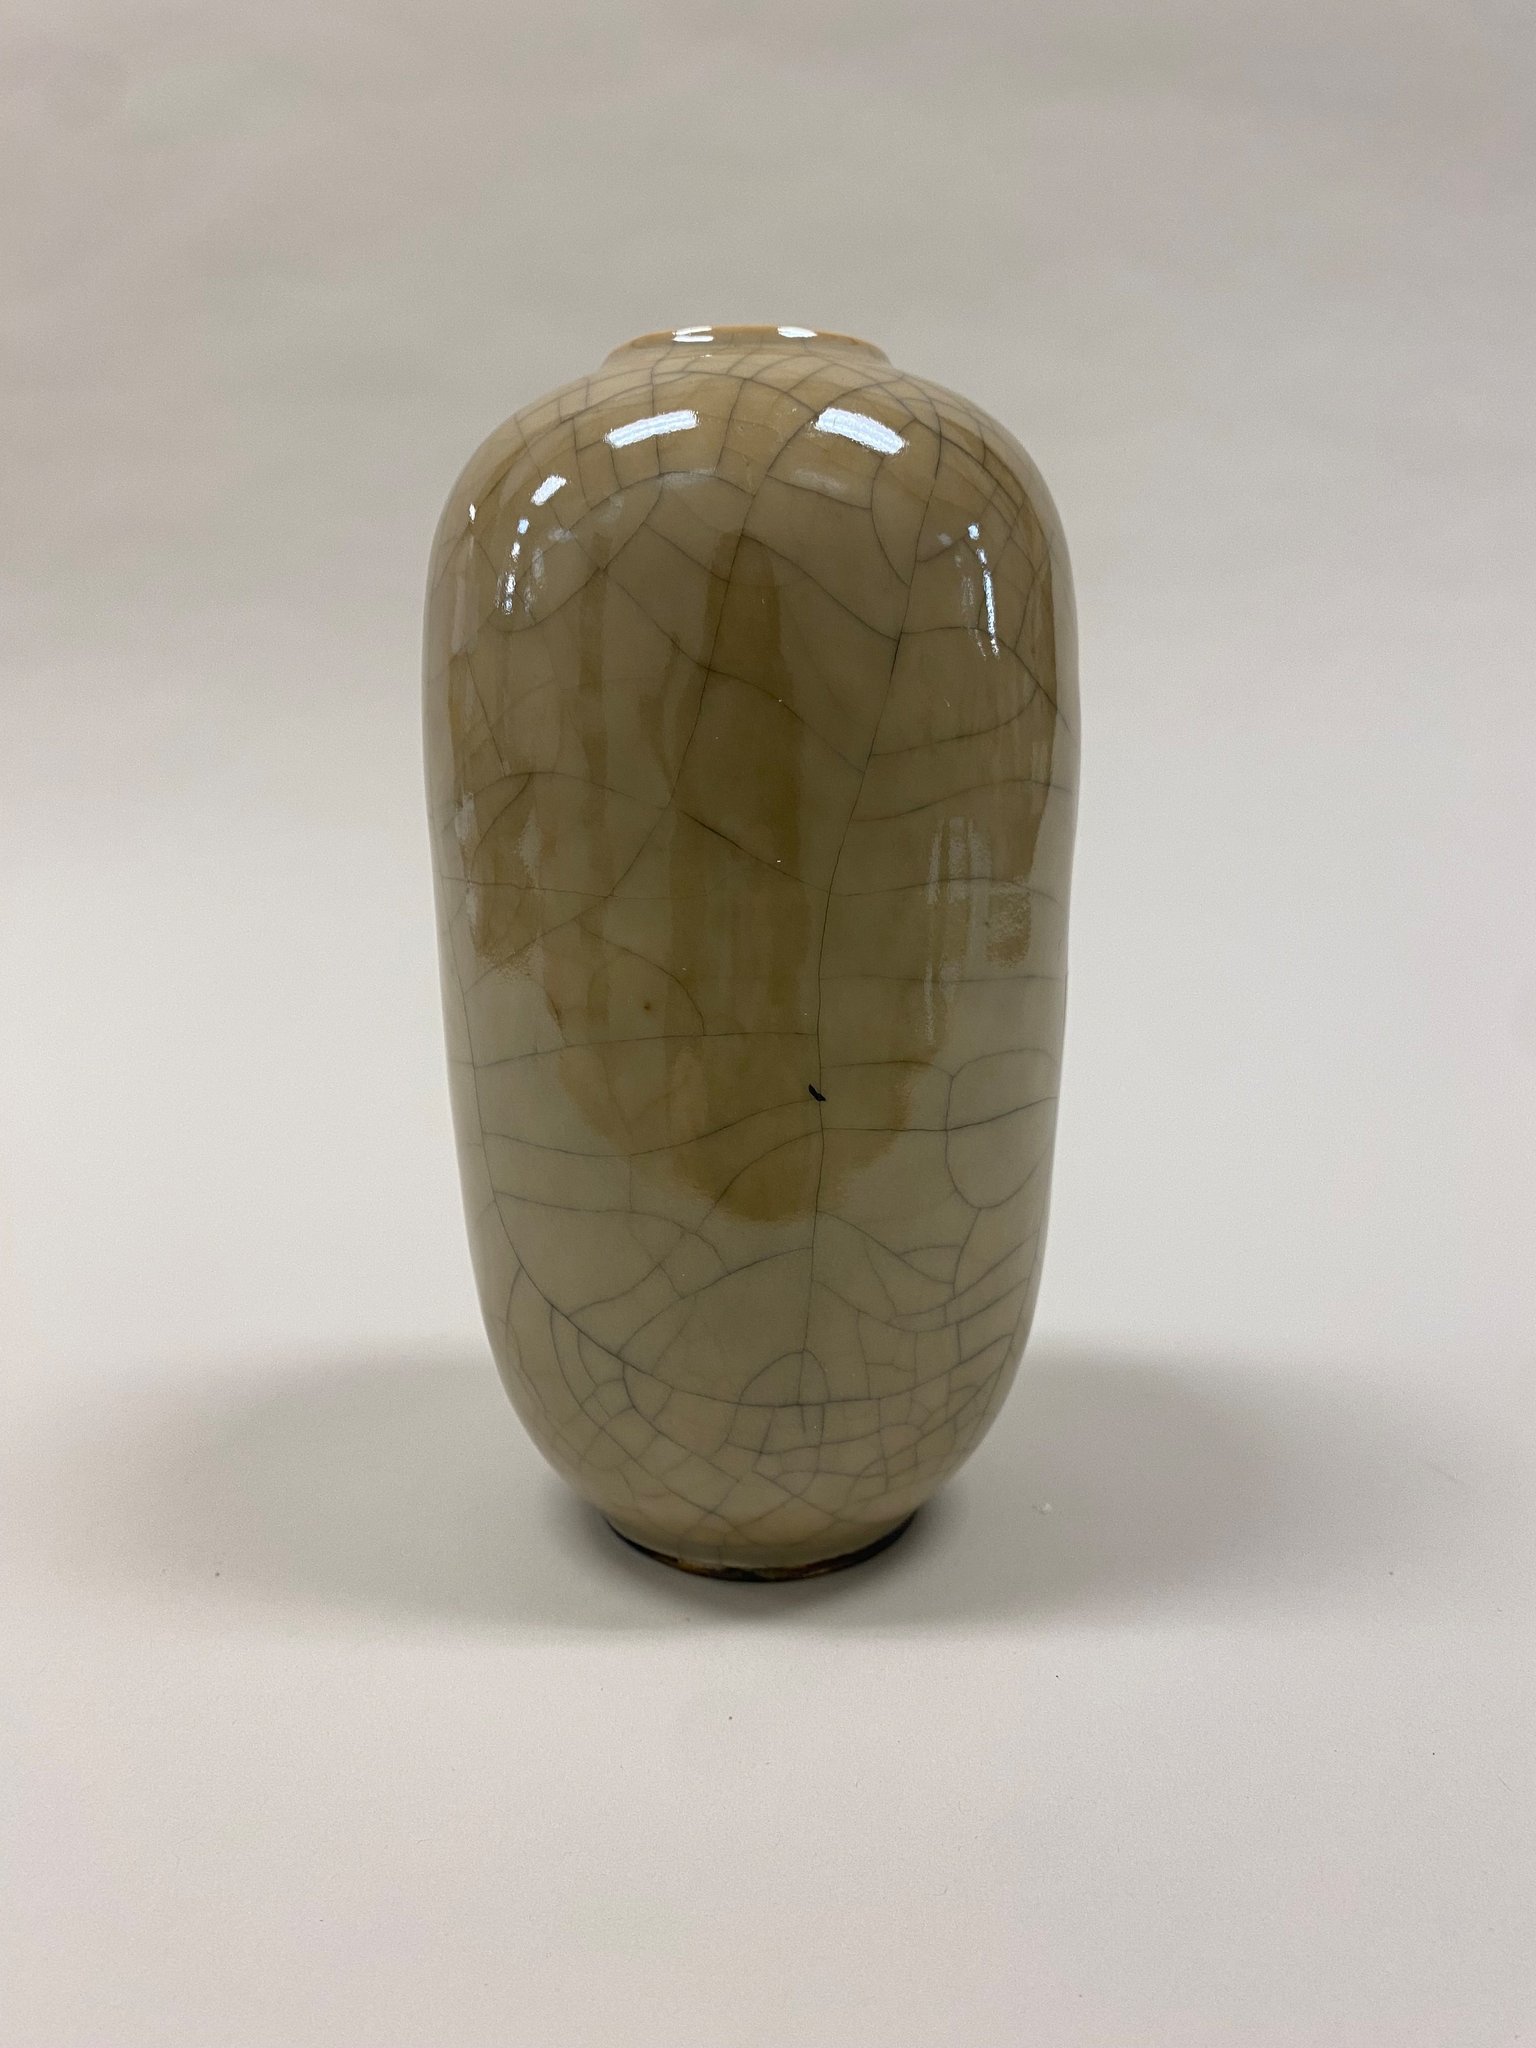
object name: vase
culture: chinese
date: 1767-1800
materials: glaze, porcelain